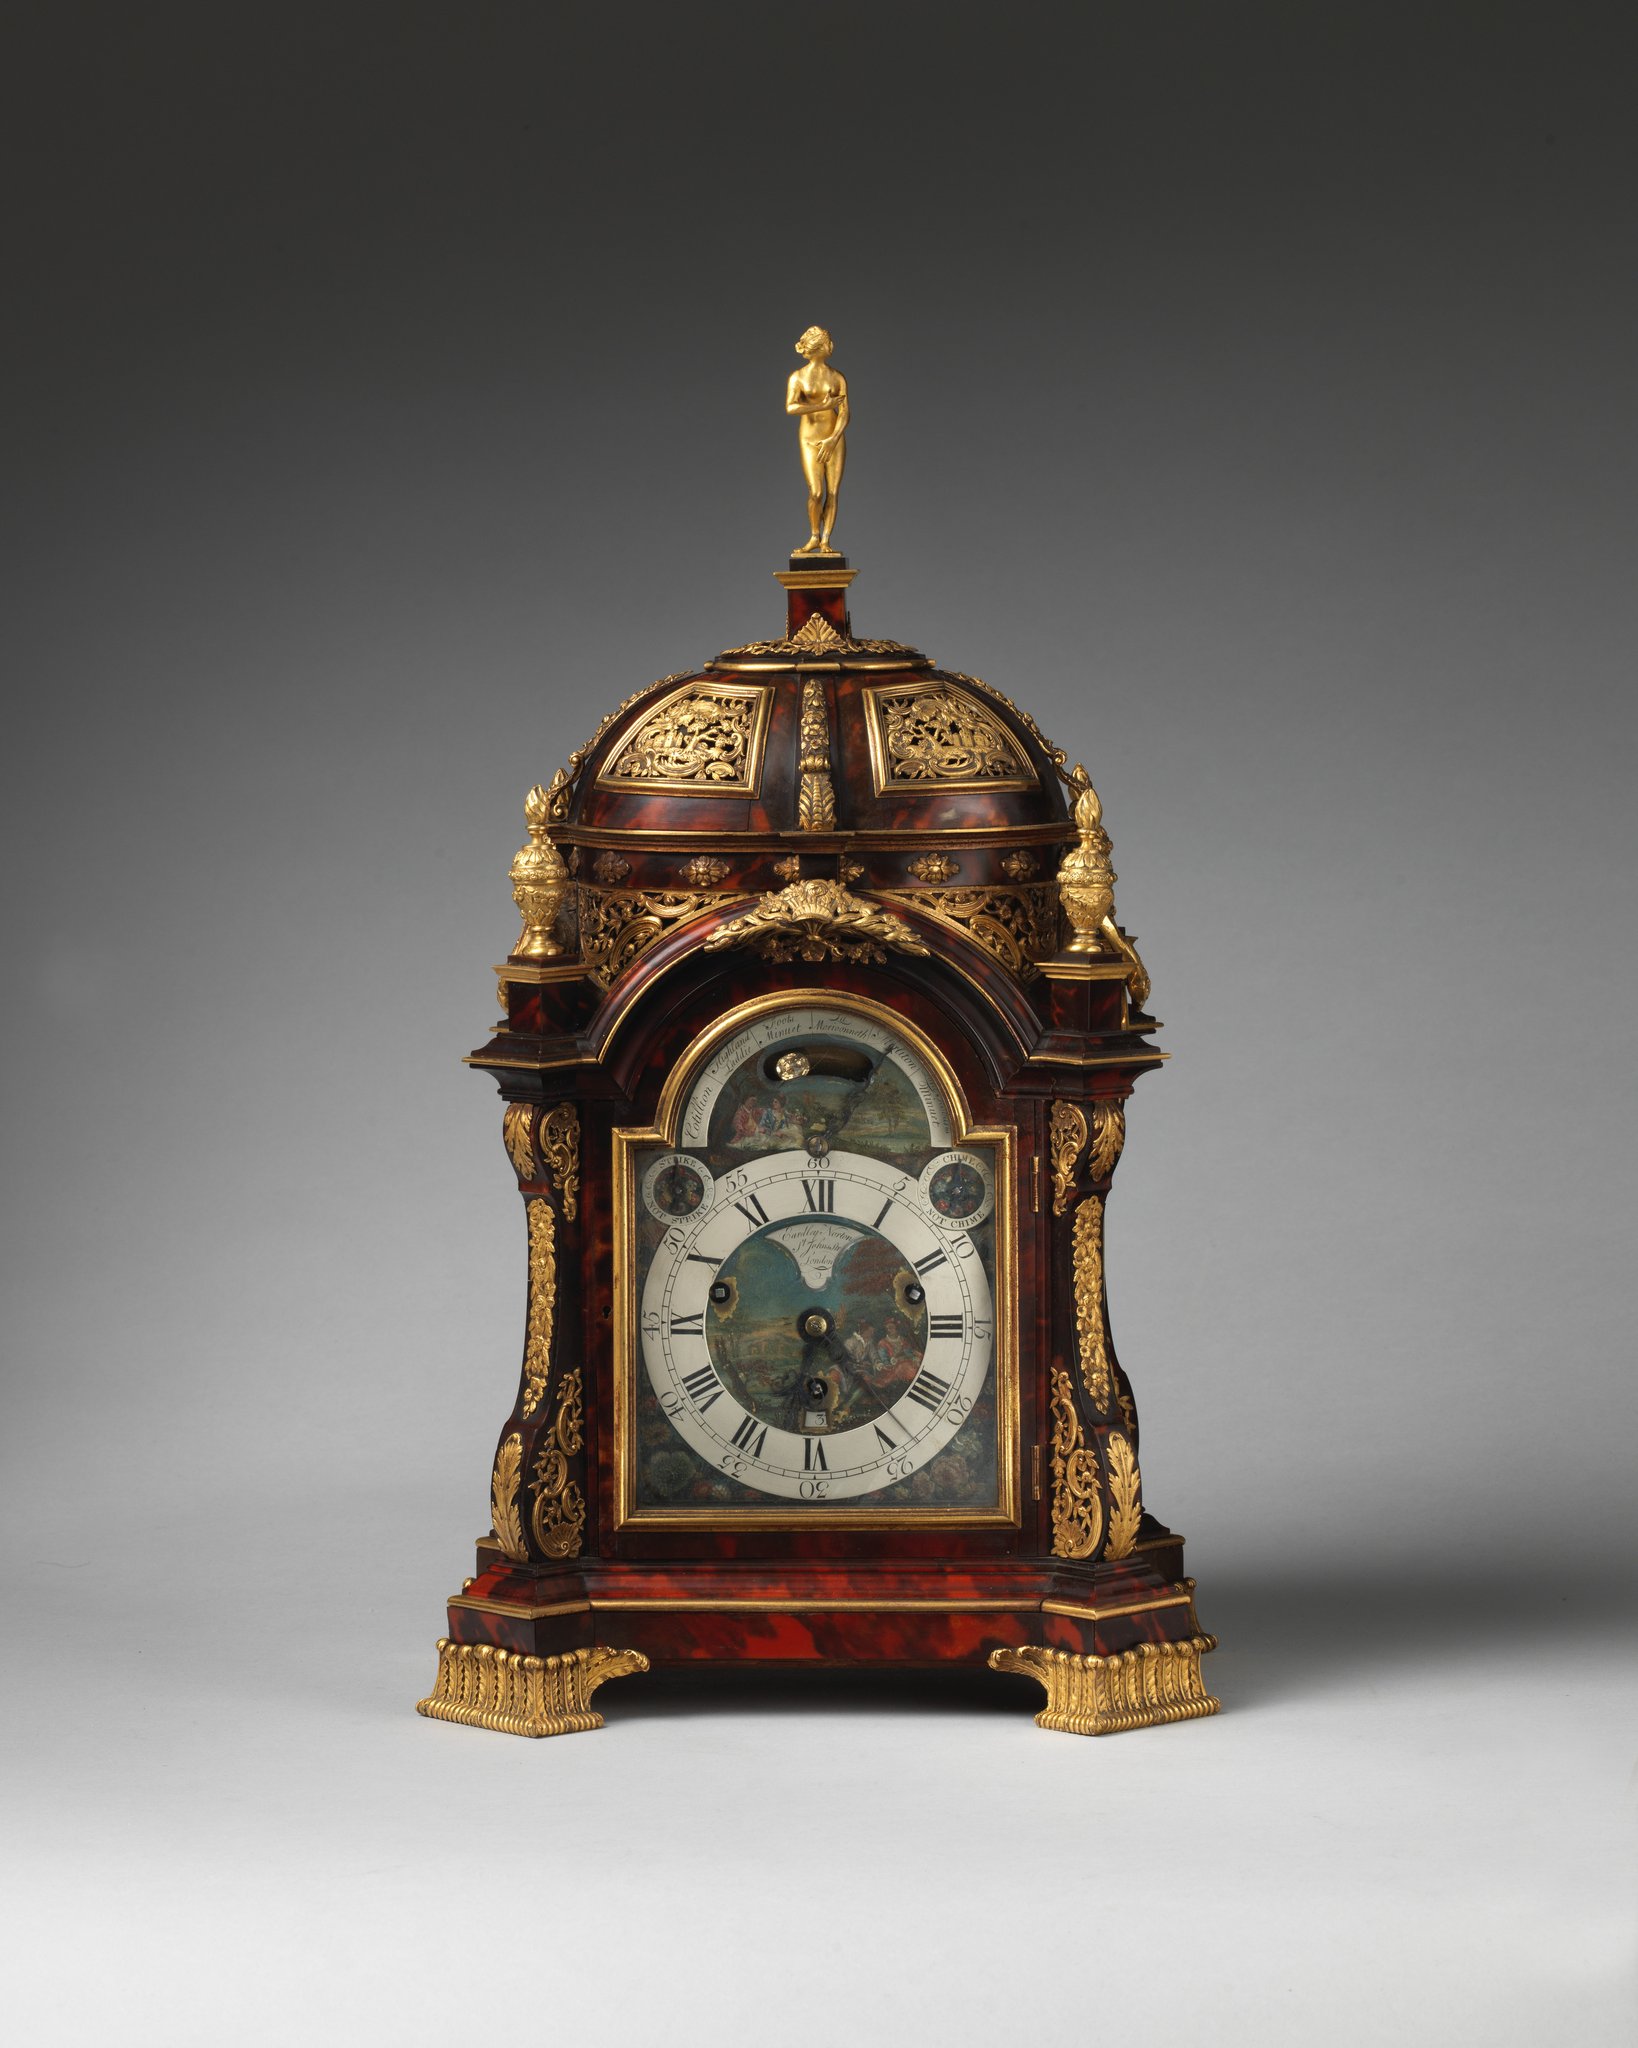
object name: musical bracket or table clock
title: Musical bracket or table clock with calendar and repeating work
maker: eardley norton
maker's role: maker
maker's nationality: british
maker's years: 1728-1792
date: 1780-1794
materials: crystal, gilt bronze, shell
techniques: engraving, painting, veneering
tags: men,women,female nudes